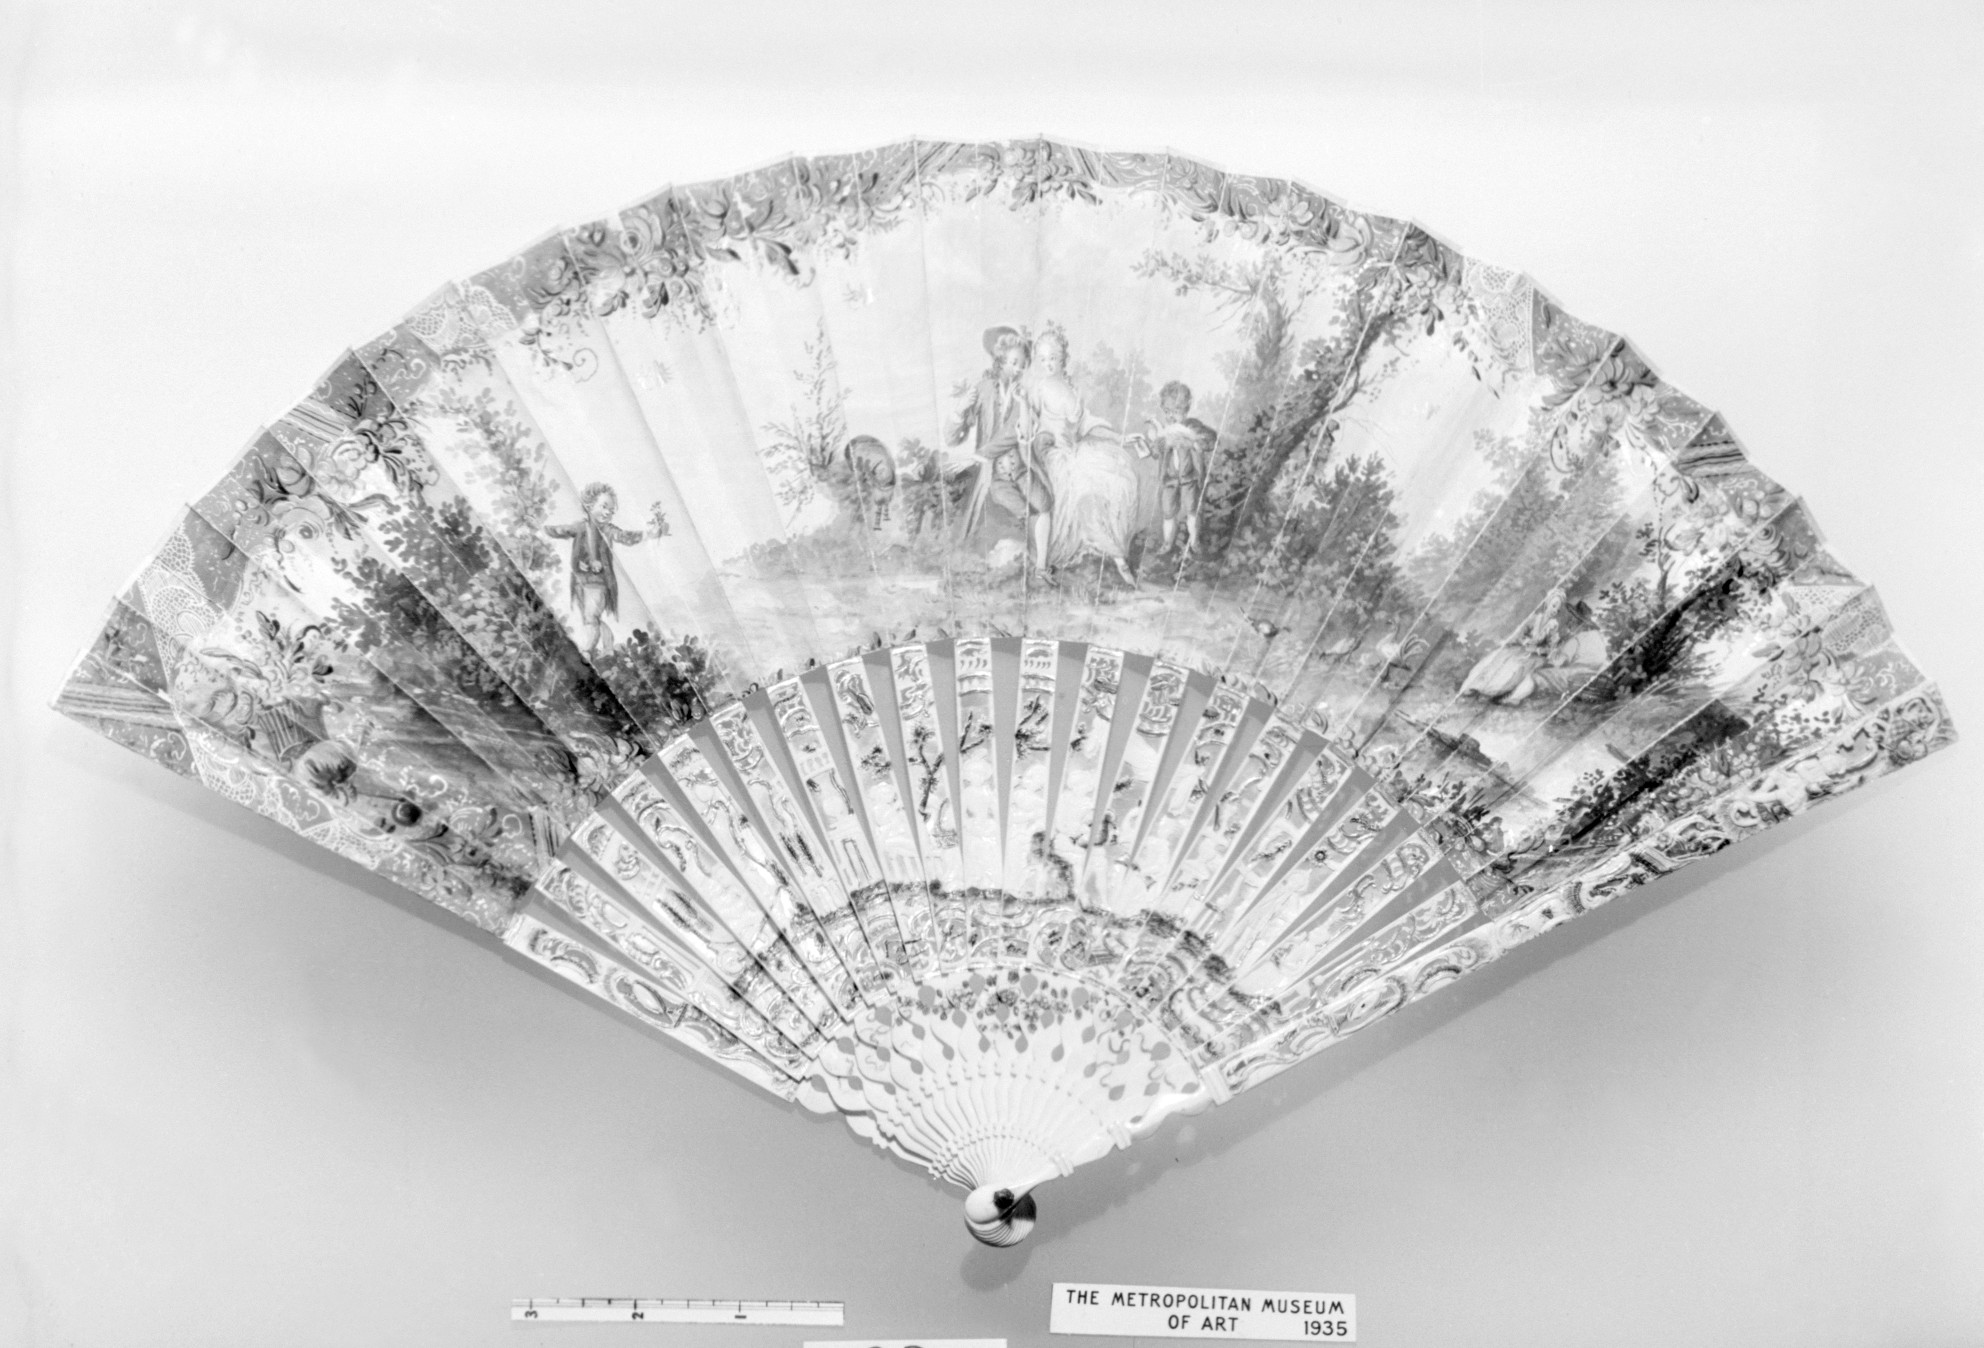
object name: fan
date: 1751-1775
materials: ivory, paper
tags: boys,men,women